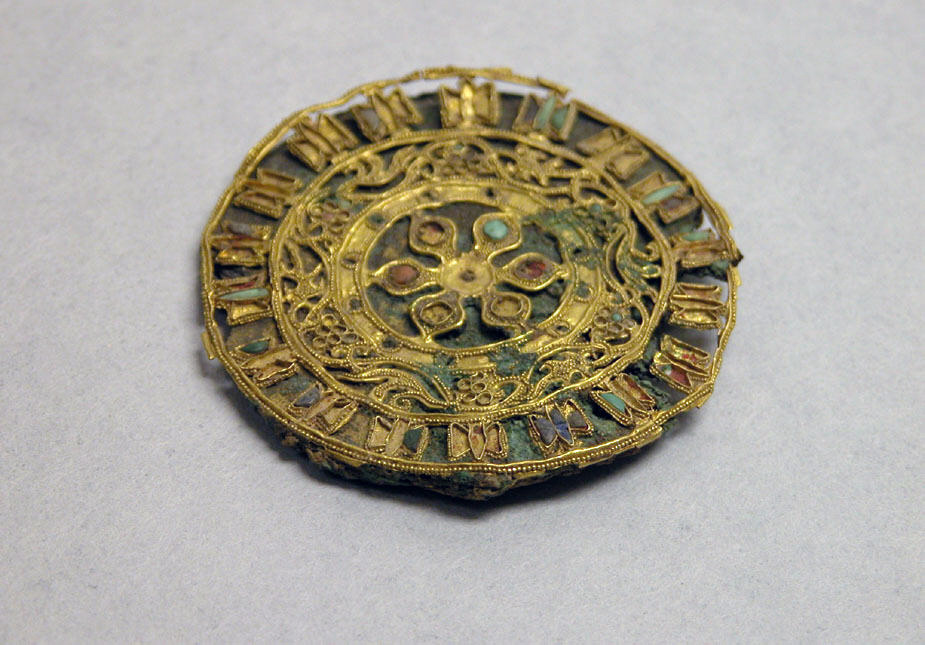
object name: ornament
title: Ornament plaque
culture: chinese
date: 201-300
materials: gold, stone